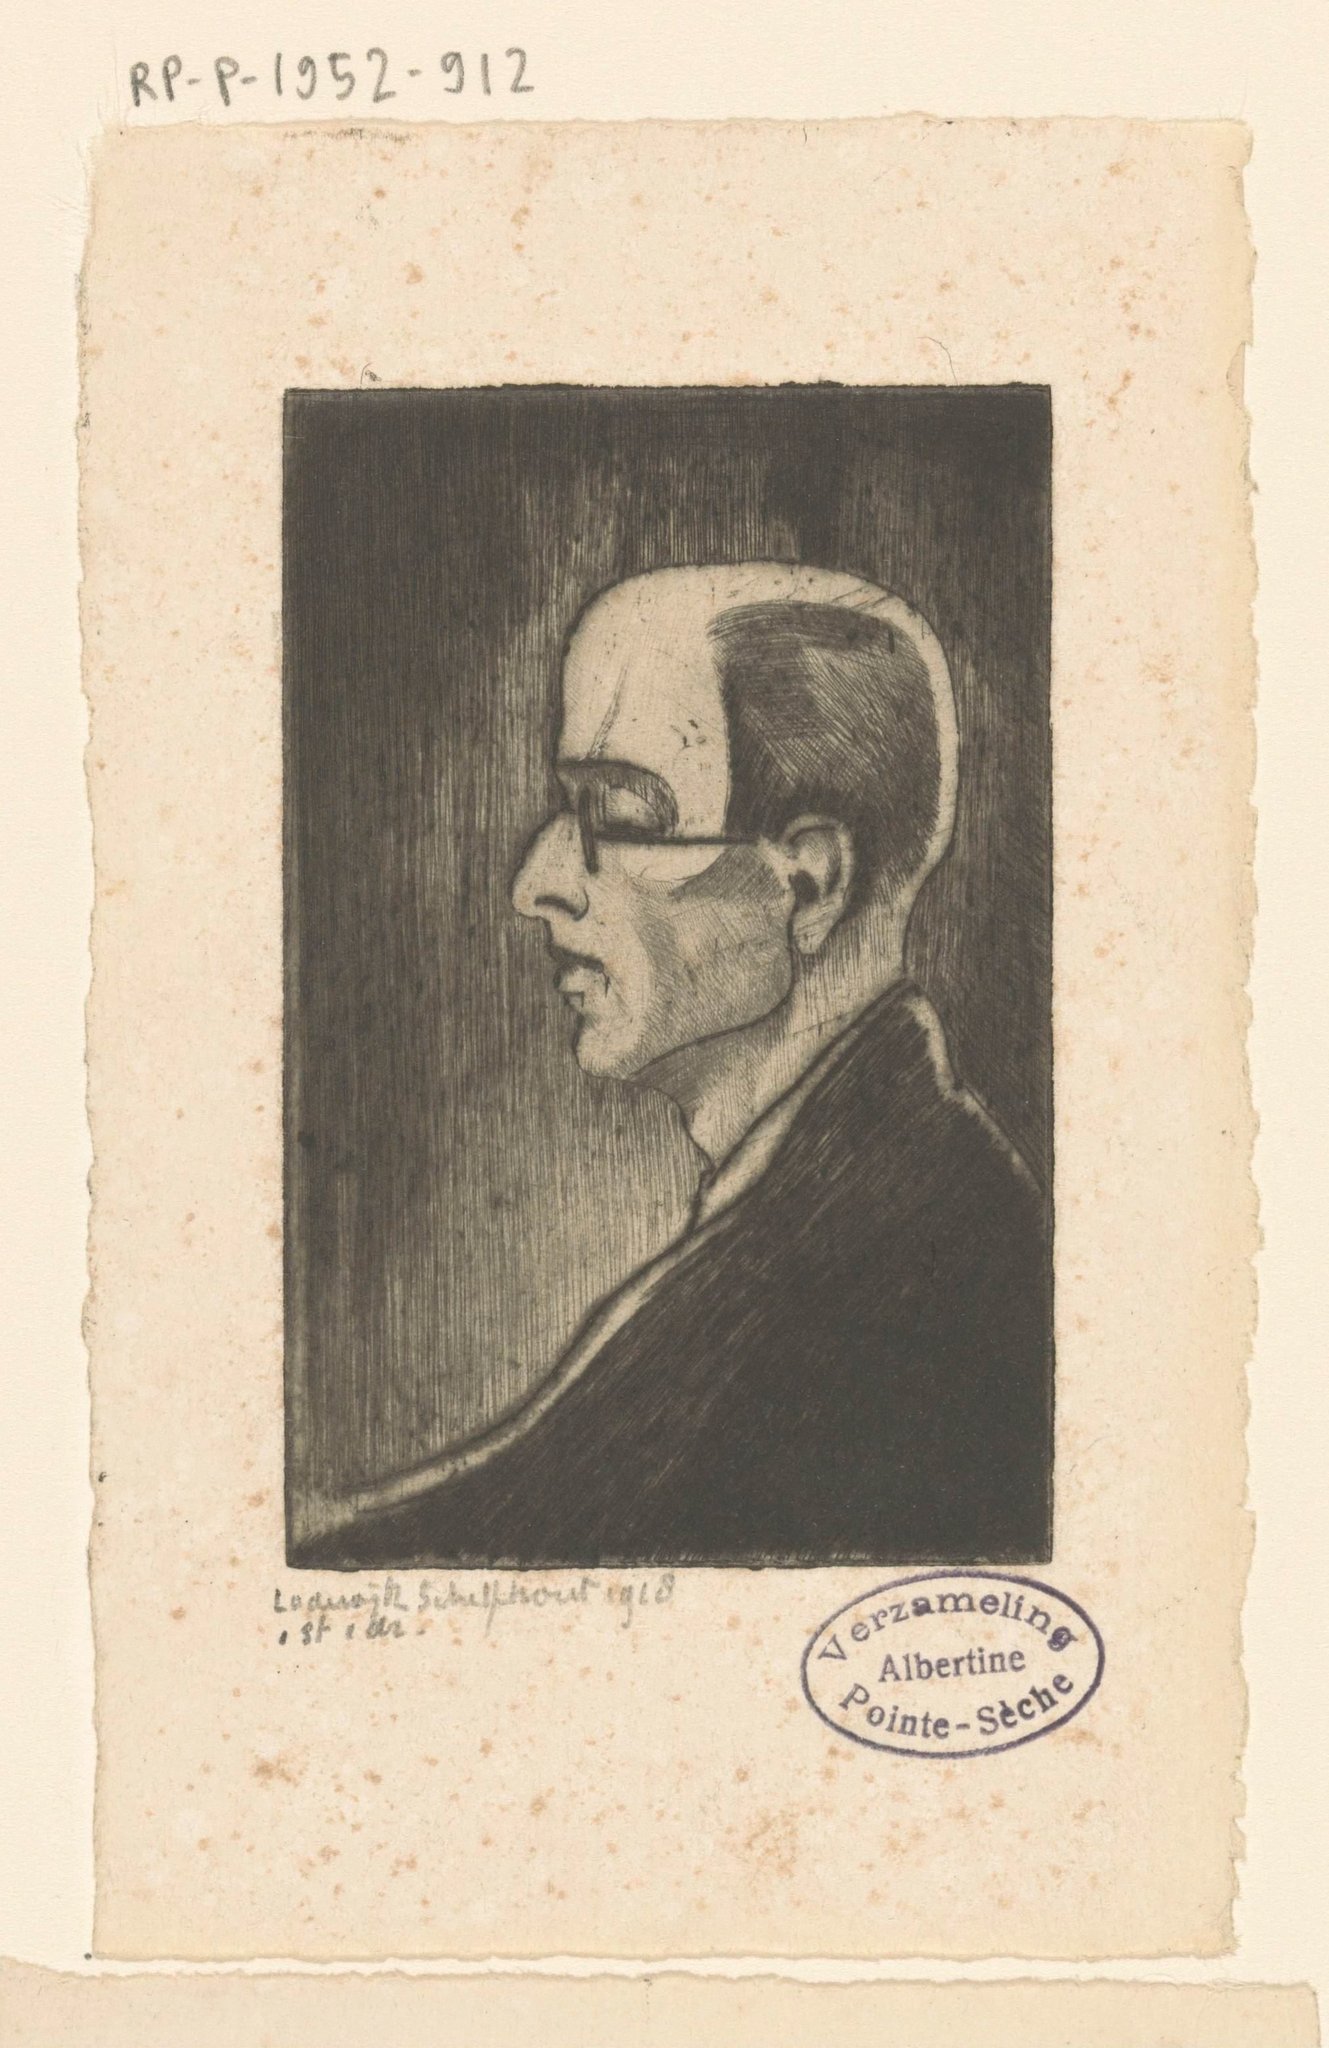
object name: print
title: Portret van Johan Verster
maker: lodewijk schelfhout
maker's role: draughtsman, print maker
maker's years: 1881-1943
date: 1918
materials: paper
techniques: drypoint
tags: blind, blindness, portrait of a musician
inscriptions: collector's mark: Lugt 2228, collector's mark: Lugt 5i, collector's mark: Lugt 2760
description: Een portret van de blinde pianist Johan Verster, met bril.